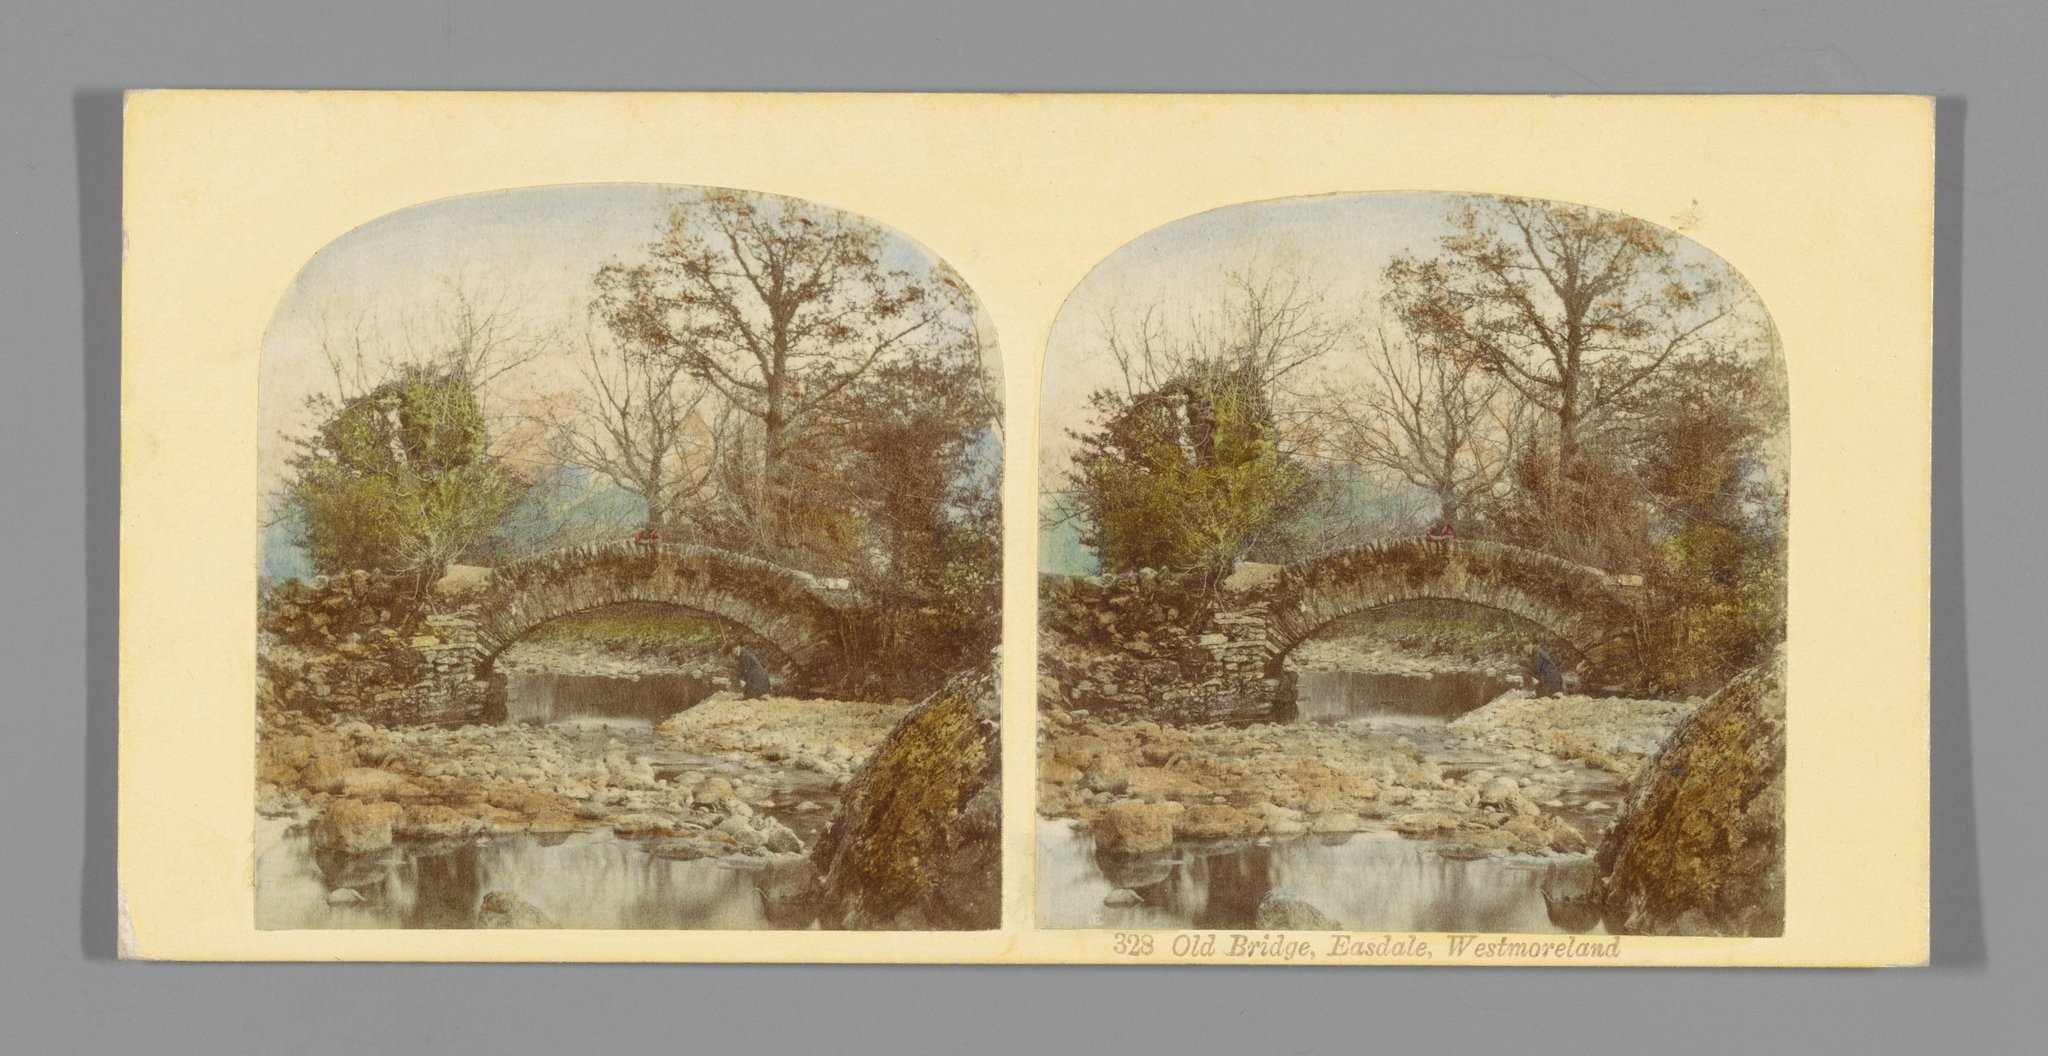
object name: stereograph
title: Old Bridge, Easdale, Westmoreland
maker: Anonymous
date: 1850-1880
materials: cardboard, photographic support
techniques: albumen print, hand coloring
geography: easdale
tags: bridge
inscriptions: number: ‘328’